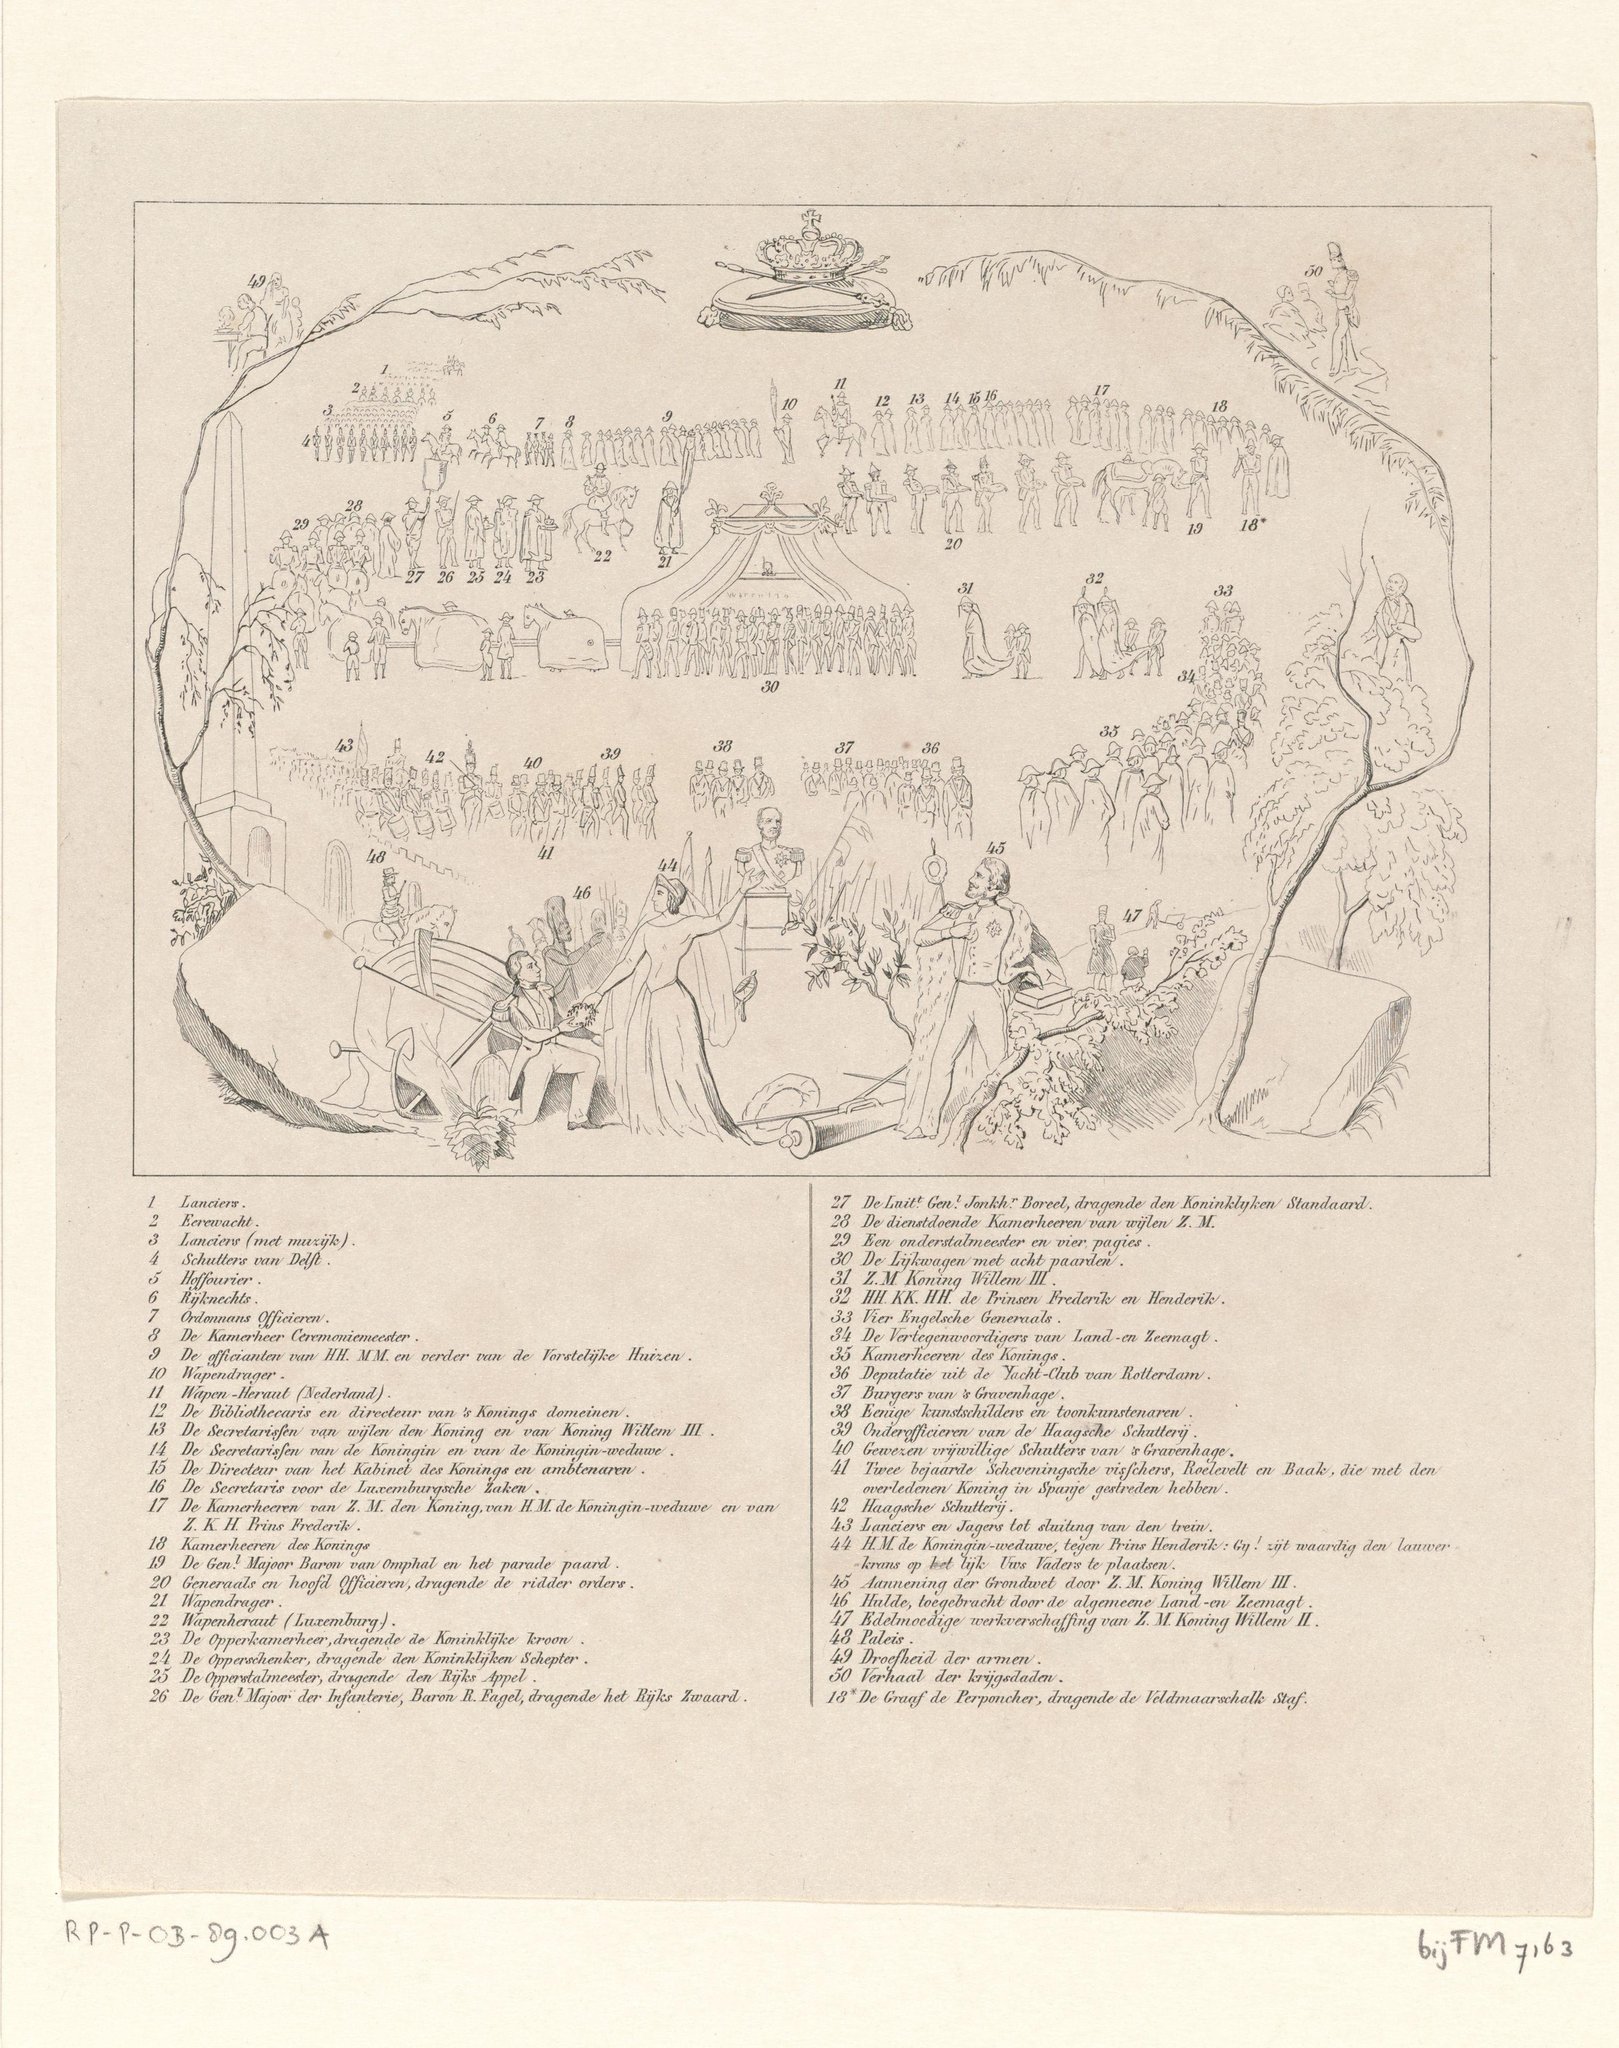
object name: print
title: Sleutel bij de prent van de begrafenis van wijlen koning Willem II te Delft op 4 april 1849.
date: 1849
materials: paper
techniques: lithograph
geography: netherlands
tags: anna paulowna romanowa, brussels, willem iii (koning der nederlanden), william ii of the netherlands, hendrik (prins der nederlanden), cortege, funeral procession, delft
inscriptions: collector's mark: Lugt 2228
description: Sleutel bij de prent van de begrafenis van wijlen koning Willem II te Delft op 4 april 1849. Verkleinde voorstelling met in twee kolommen de nummers 1-50 met de namen van de voorgestelden.